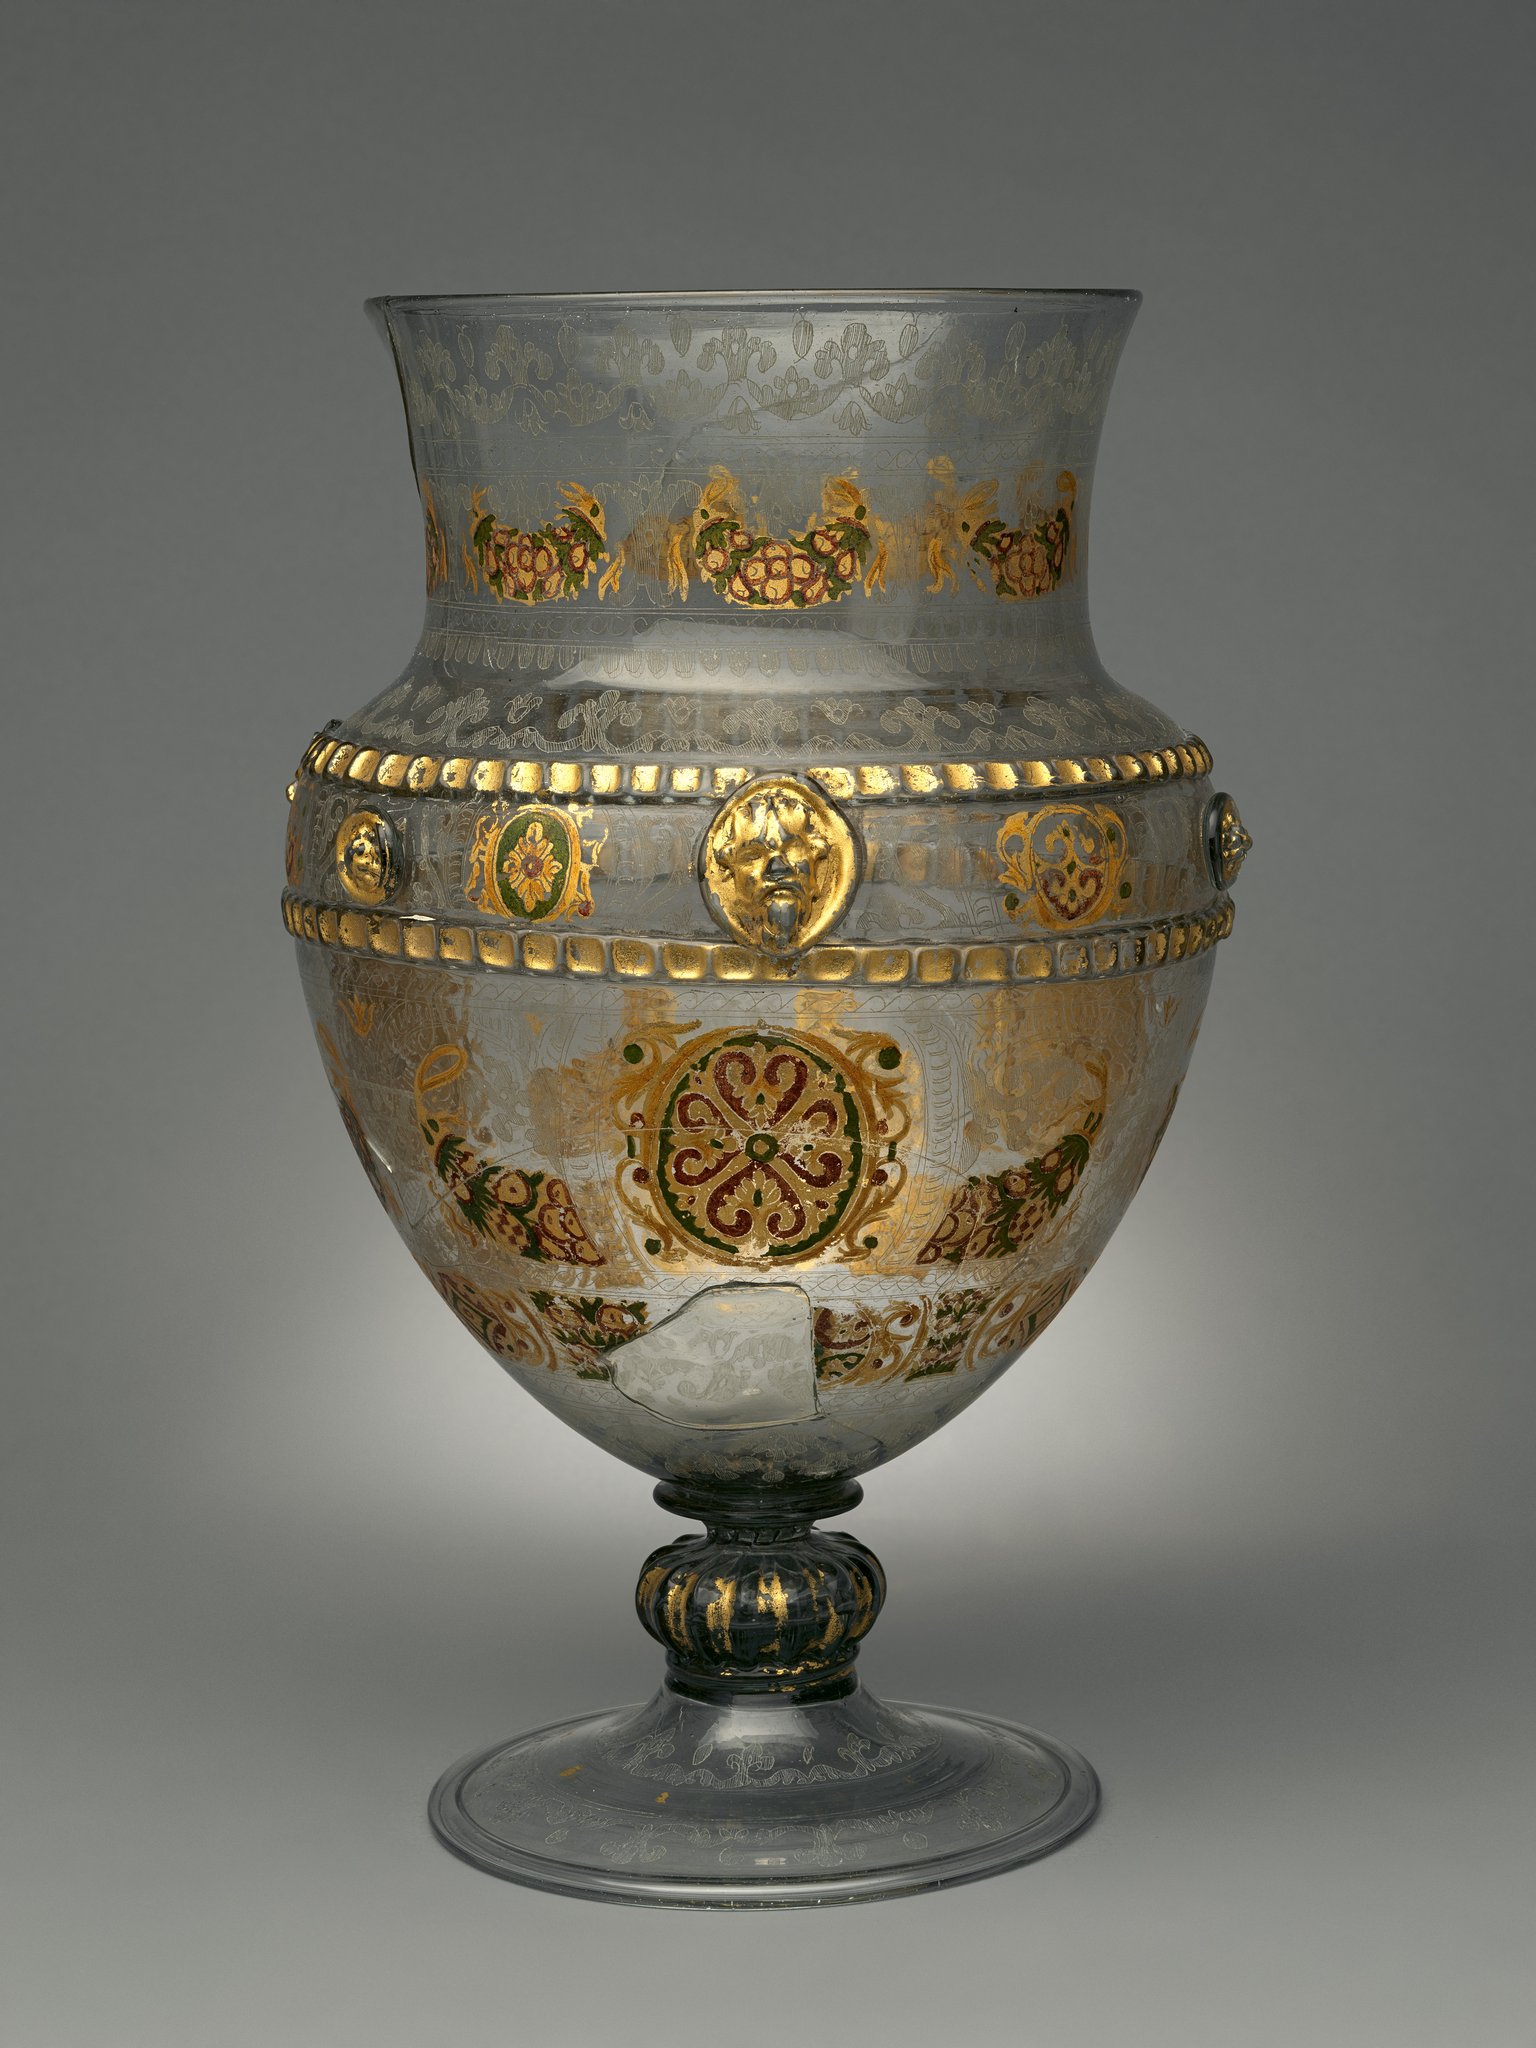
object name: vase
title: Footed vase (Vasenpokal)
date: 1570-1590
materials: glass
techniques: glassblowing, engraving, gilding, painting